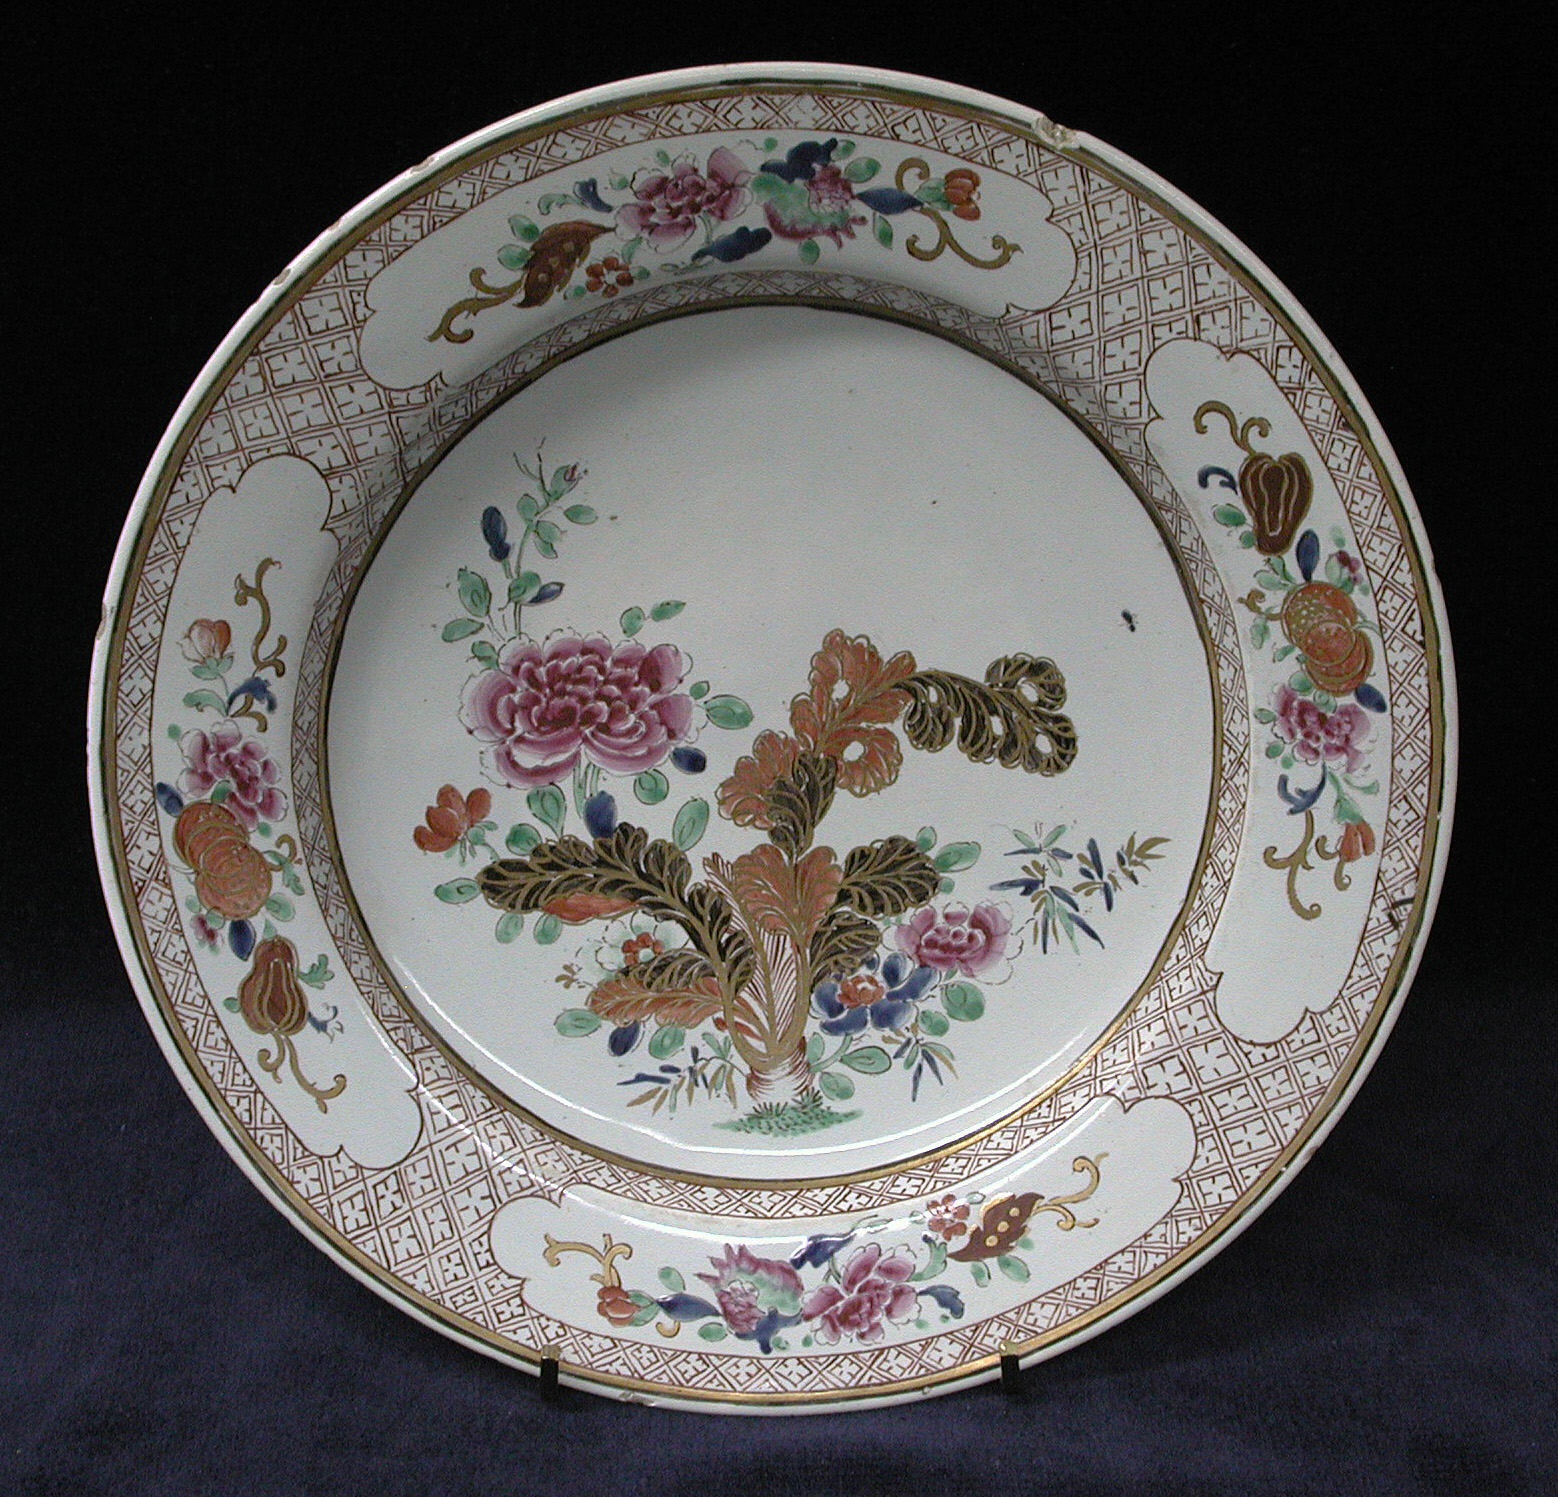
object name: plate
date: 1765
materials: earthenware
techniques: glazing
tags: flowers